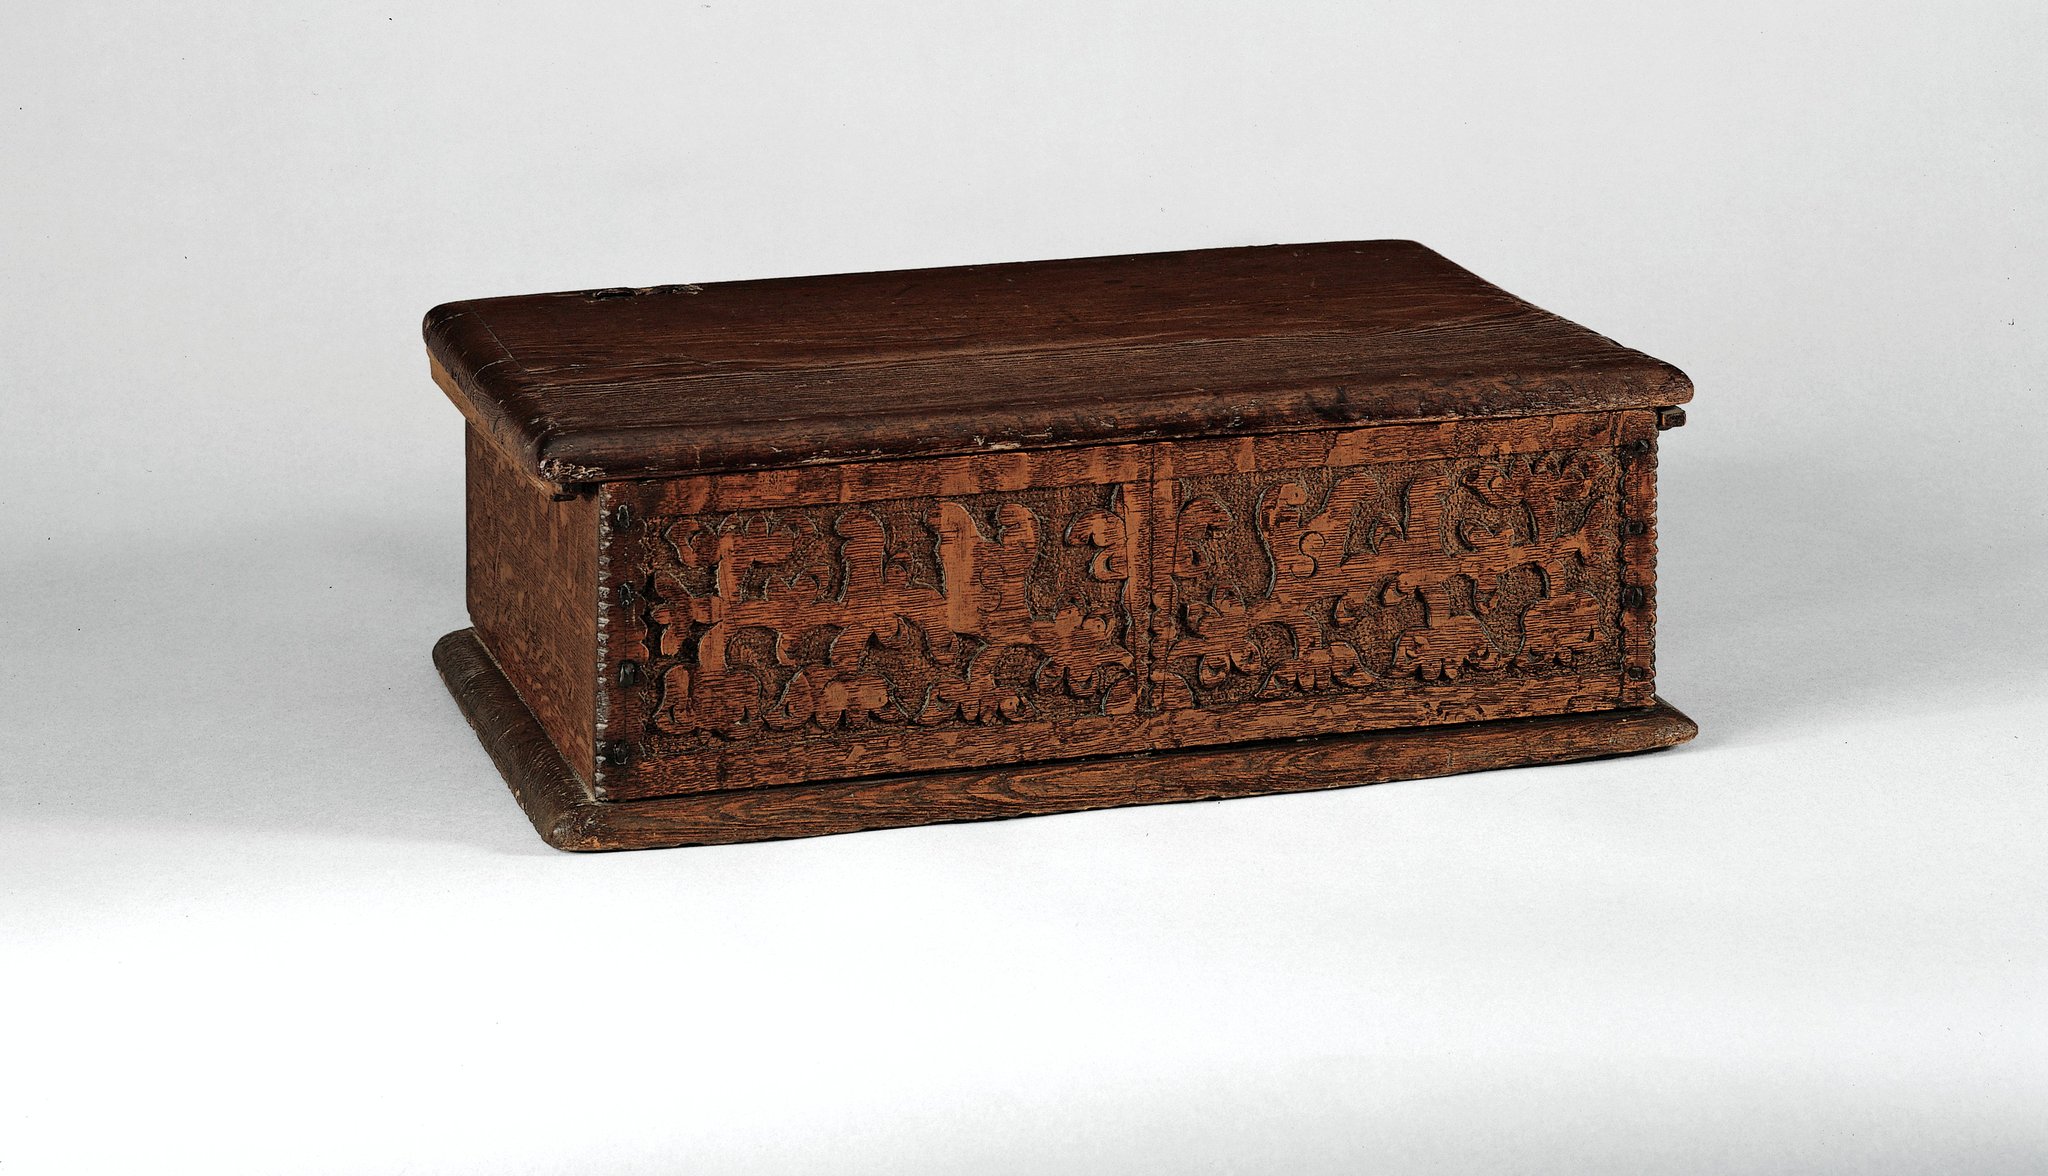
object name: box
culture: american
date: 1675-1700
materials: wood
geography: united states